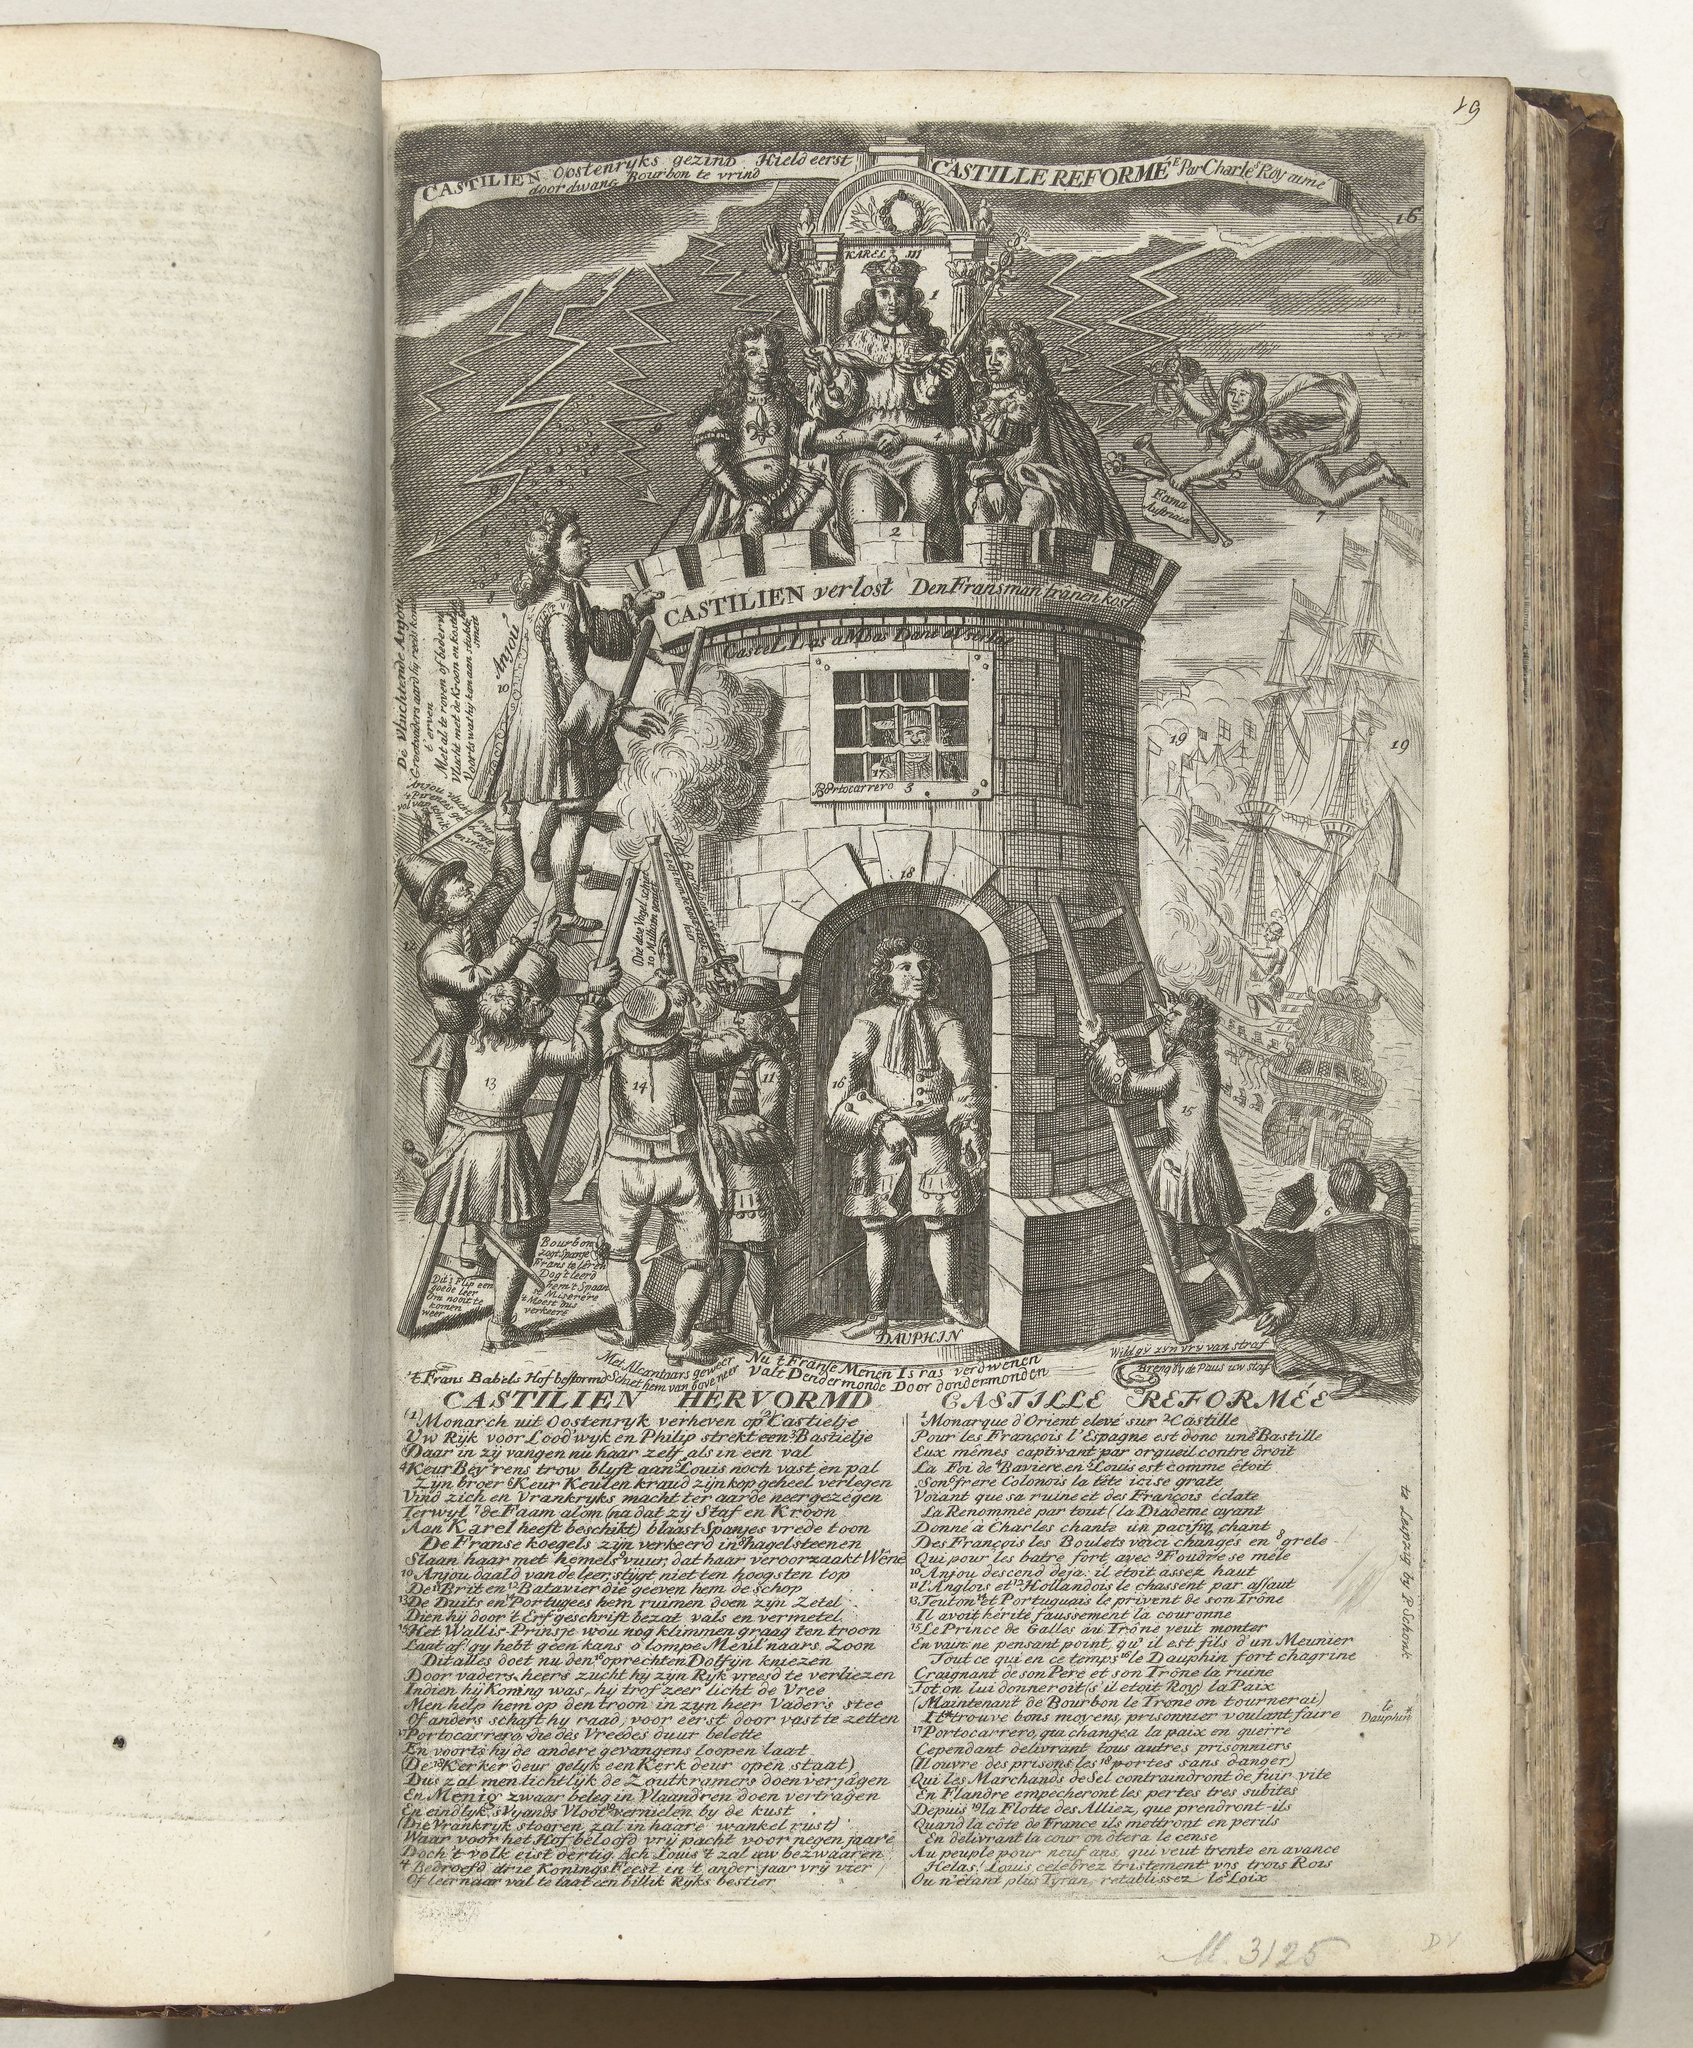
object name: print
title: Castilien Hervormd / Castille Reformée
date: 1706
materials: paper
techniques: etching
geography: amsterdam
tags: lodewijk xiv (koning van frankrijk), maximiliaan ii emanuel (keurvorst van beieren), political caricatures and satires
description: Spotprent op de partijen vechtend om Castilië, 1706. Bovenop een kasteel zitten de keurvorst van Beieren en Lodewijk XIV. Anderen proberen op de toren te klimmen. In de plaat verzen in het Nederlands en Frans. Blad nr. 16 (genummerd rechtsboven) in de serie van 25 bladen getiteld: Byvoegsel tot de Koninglyke Almanach, genaamd het Gulde-Jaar der Bondgenooten, 1706. Onderdeel van het prentwerk uitgegeven onder de verzameltitel: 't Lust-Hof van Momus, met de gebundelde series van spotprenten tijdens de jaren 1701-1713 van de Spaanse Successieoorlog.